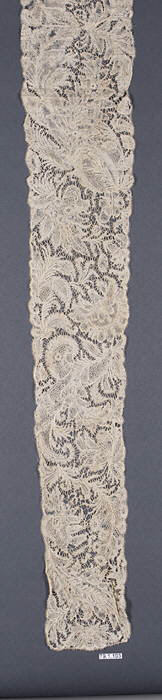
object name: lappet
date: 1725-1750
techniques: lace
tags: flowers